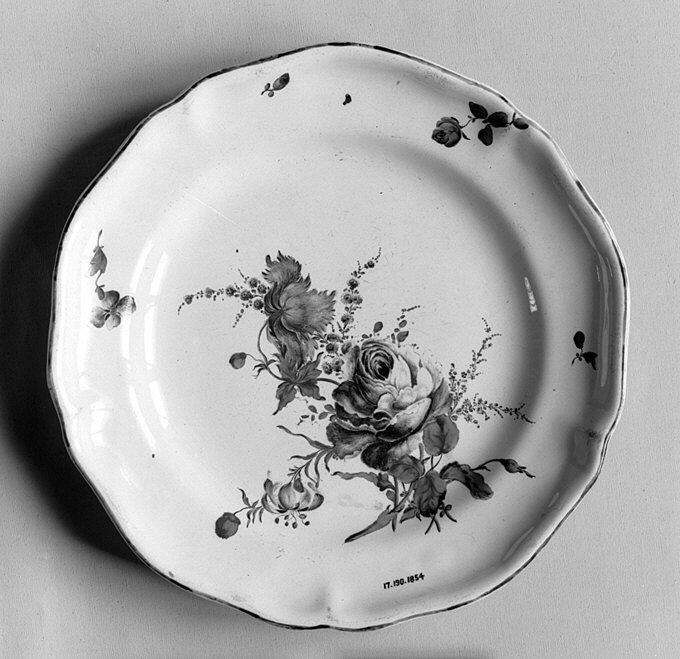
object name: plate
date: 1770-1774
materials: faience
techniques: glazing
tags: roses